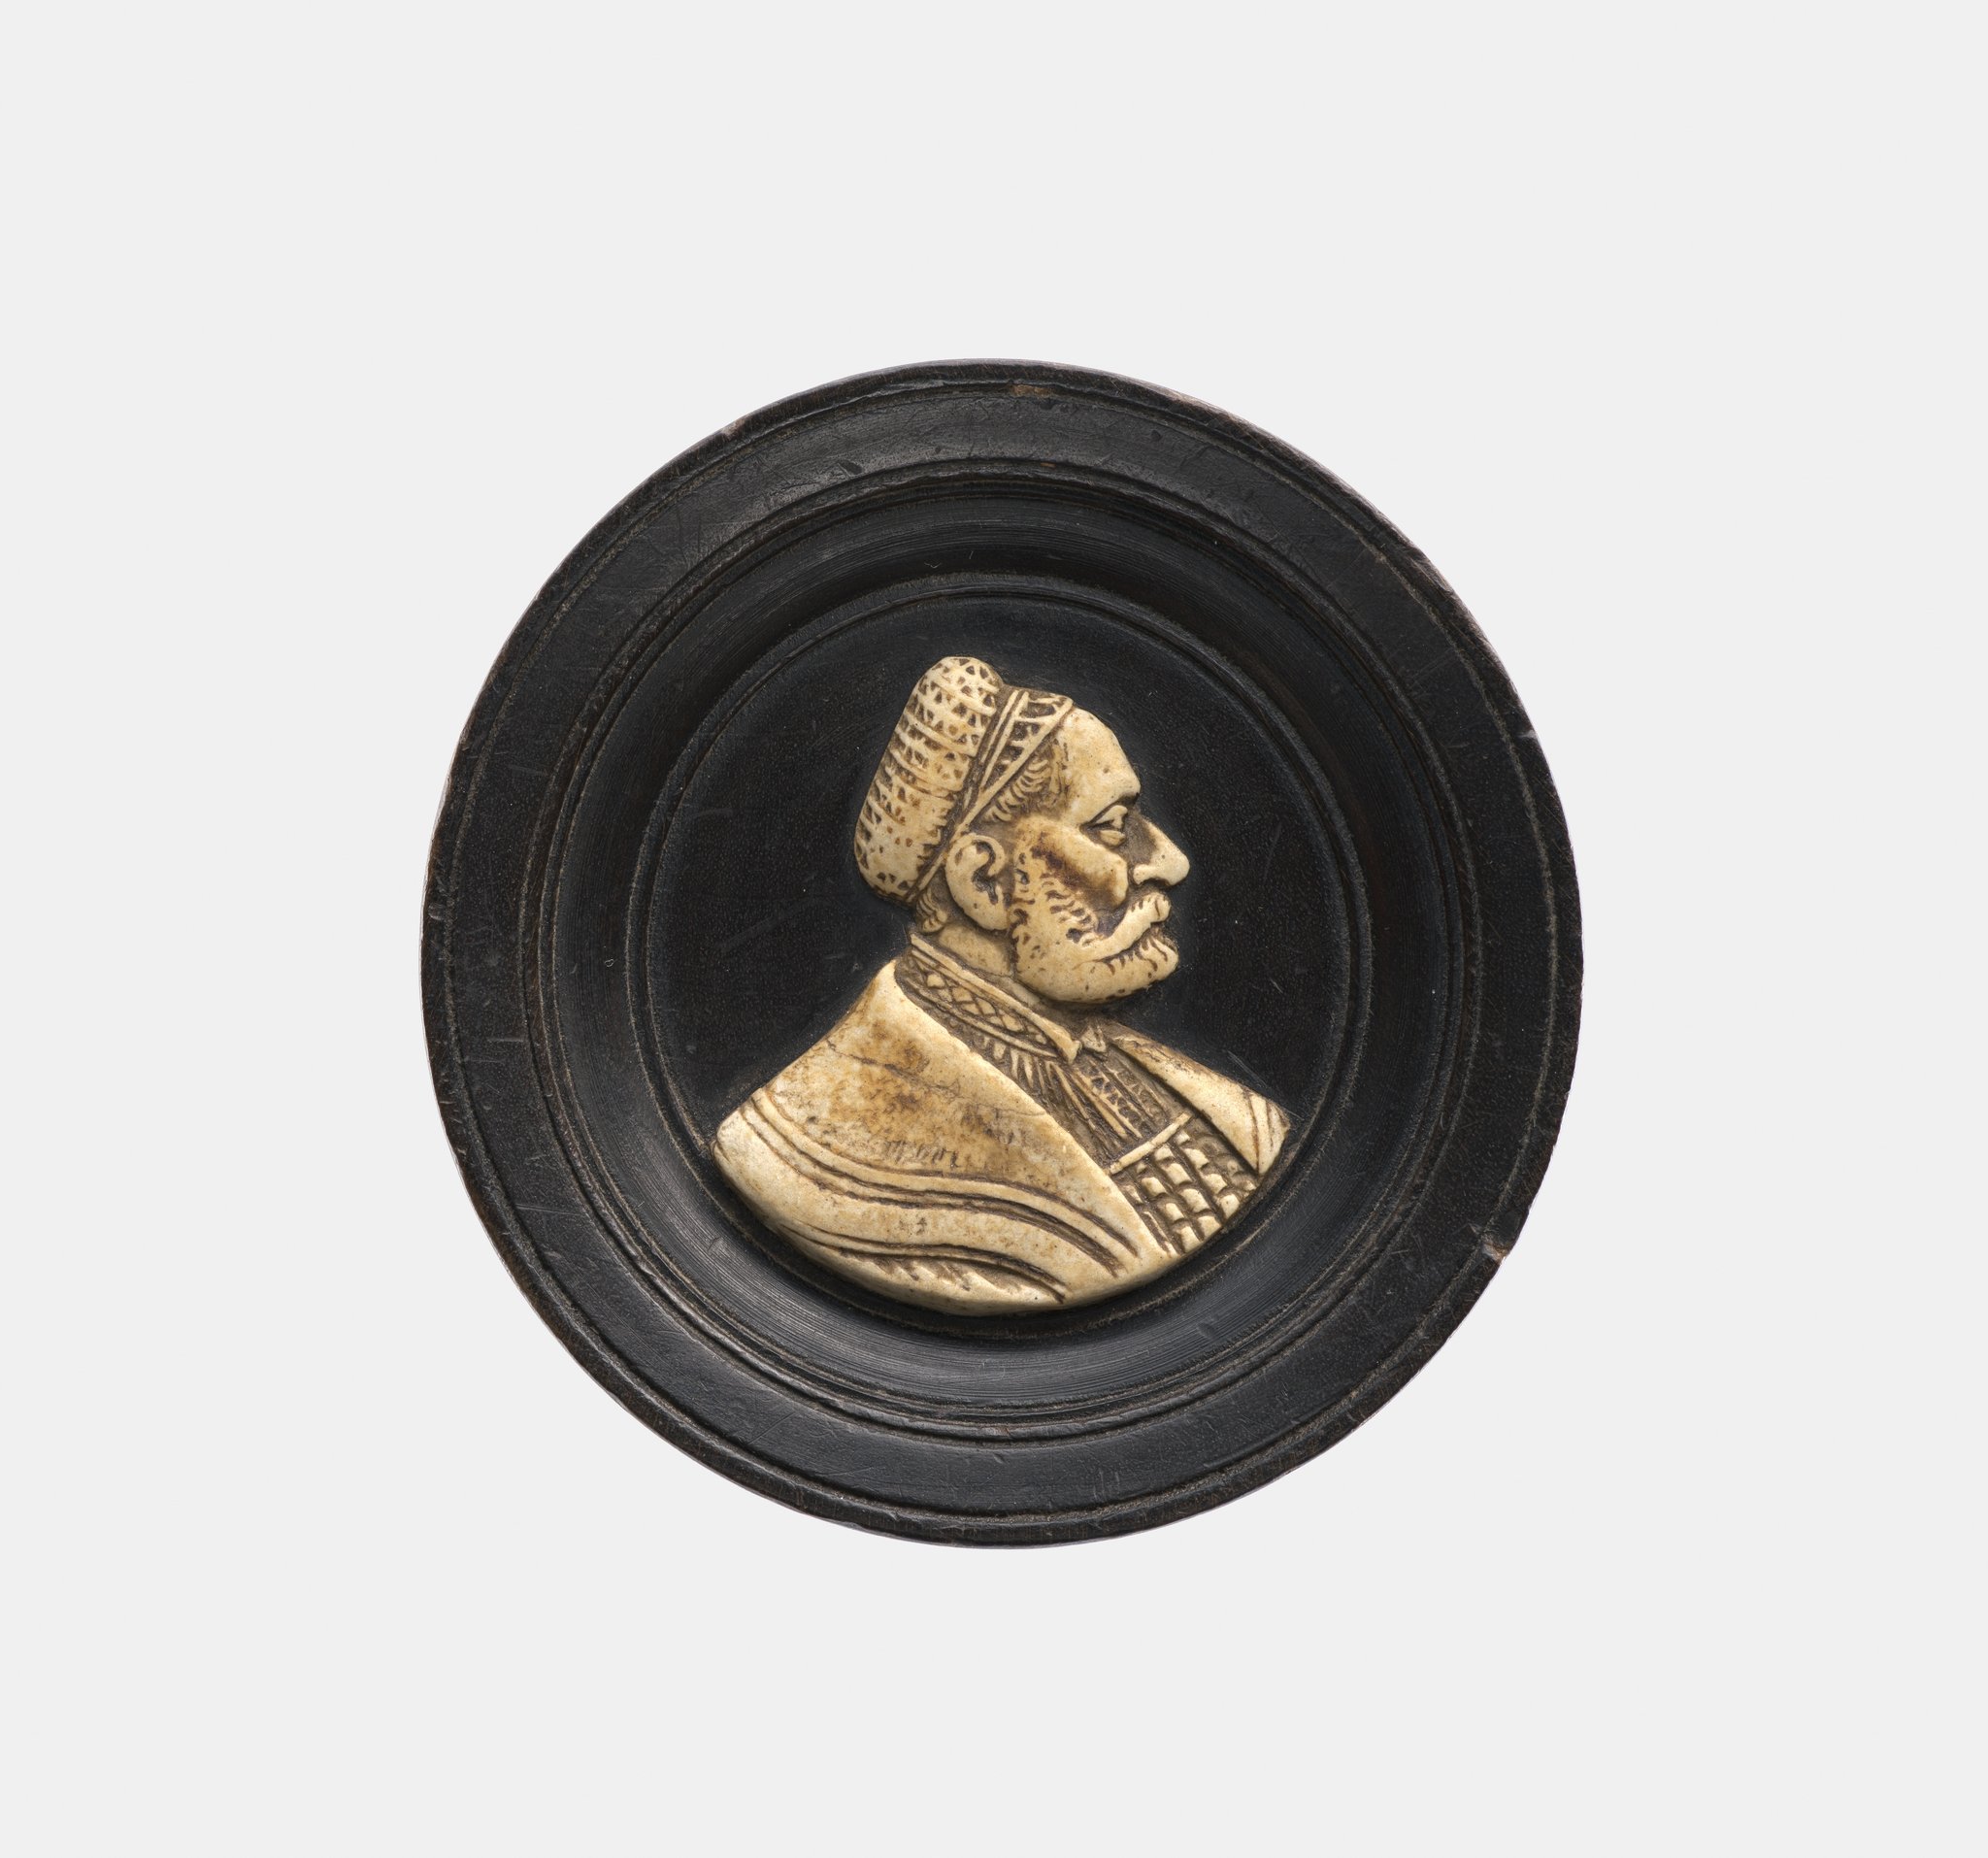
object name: checker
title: Frederick Behaim von Schwarzbach 1491-1533, Nürnberg Councilman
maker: Anonymous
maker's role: artist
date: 1530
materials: wood, marble